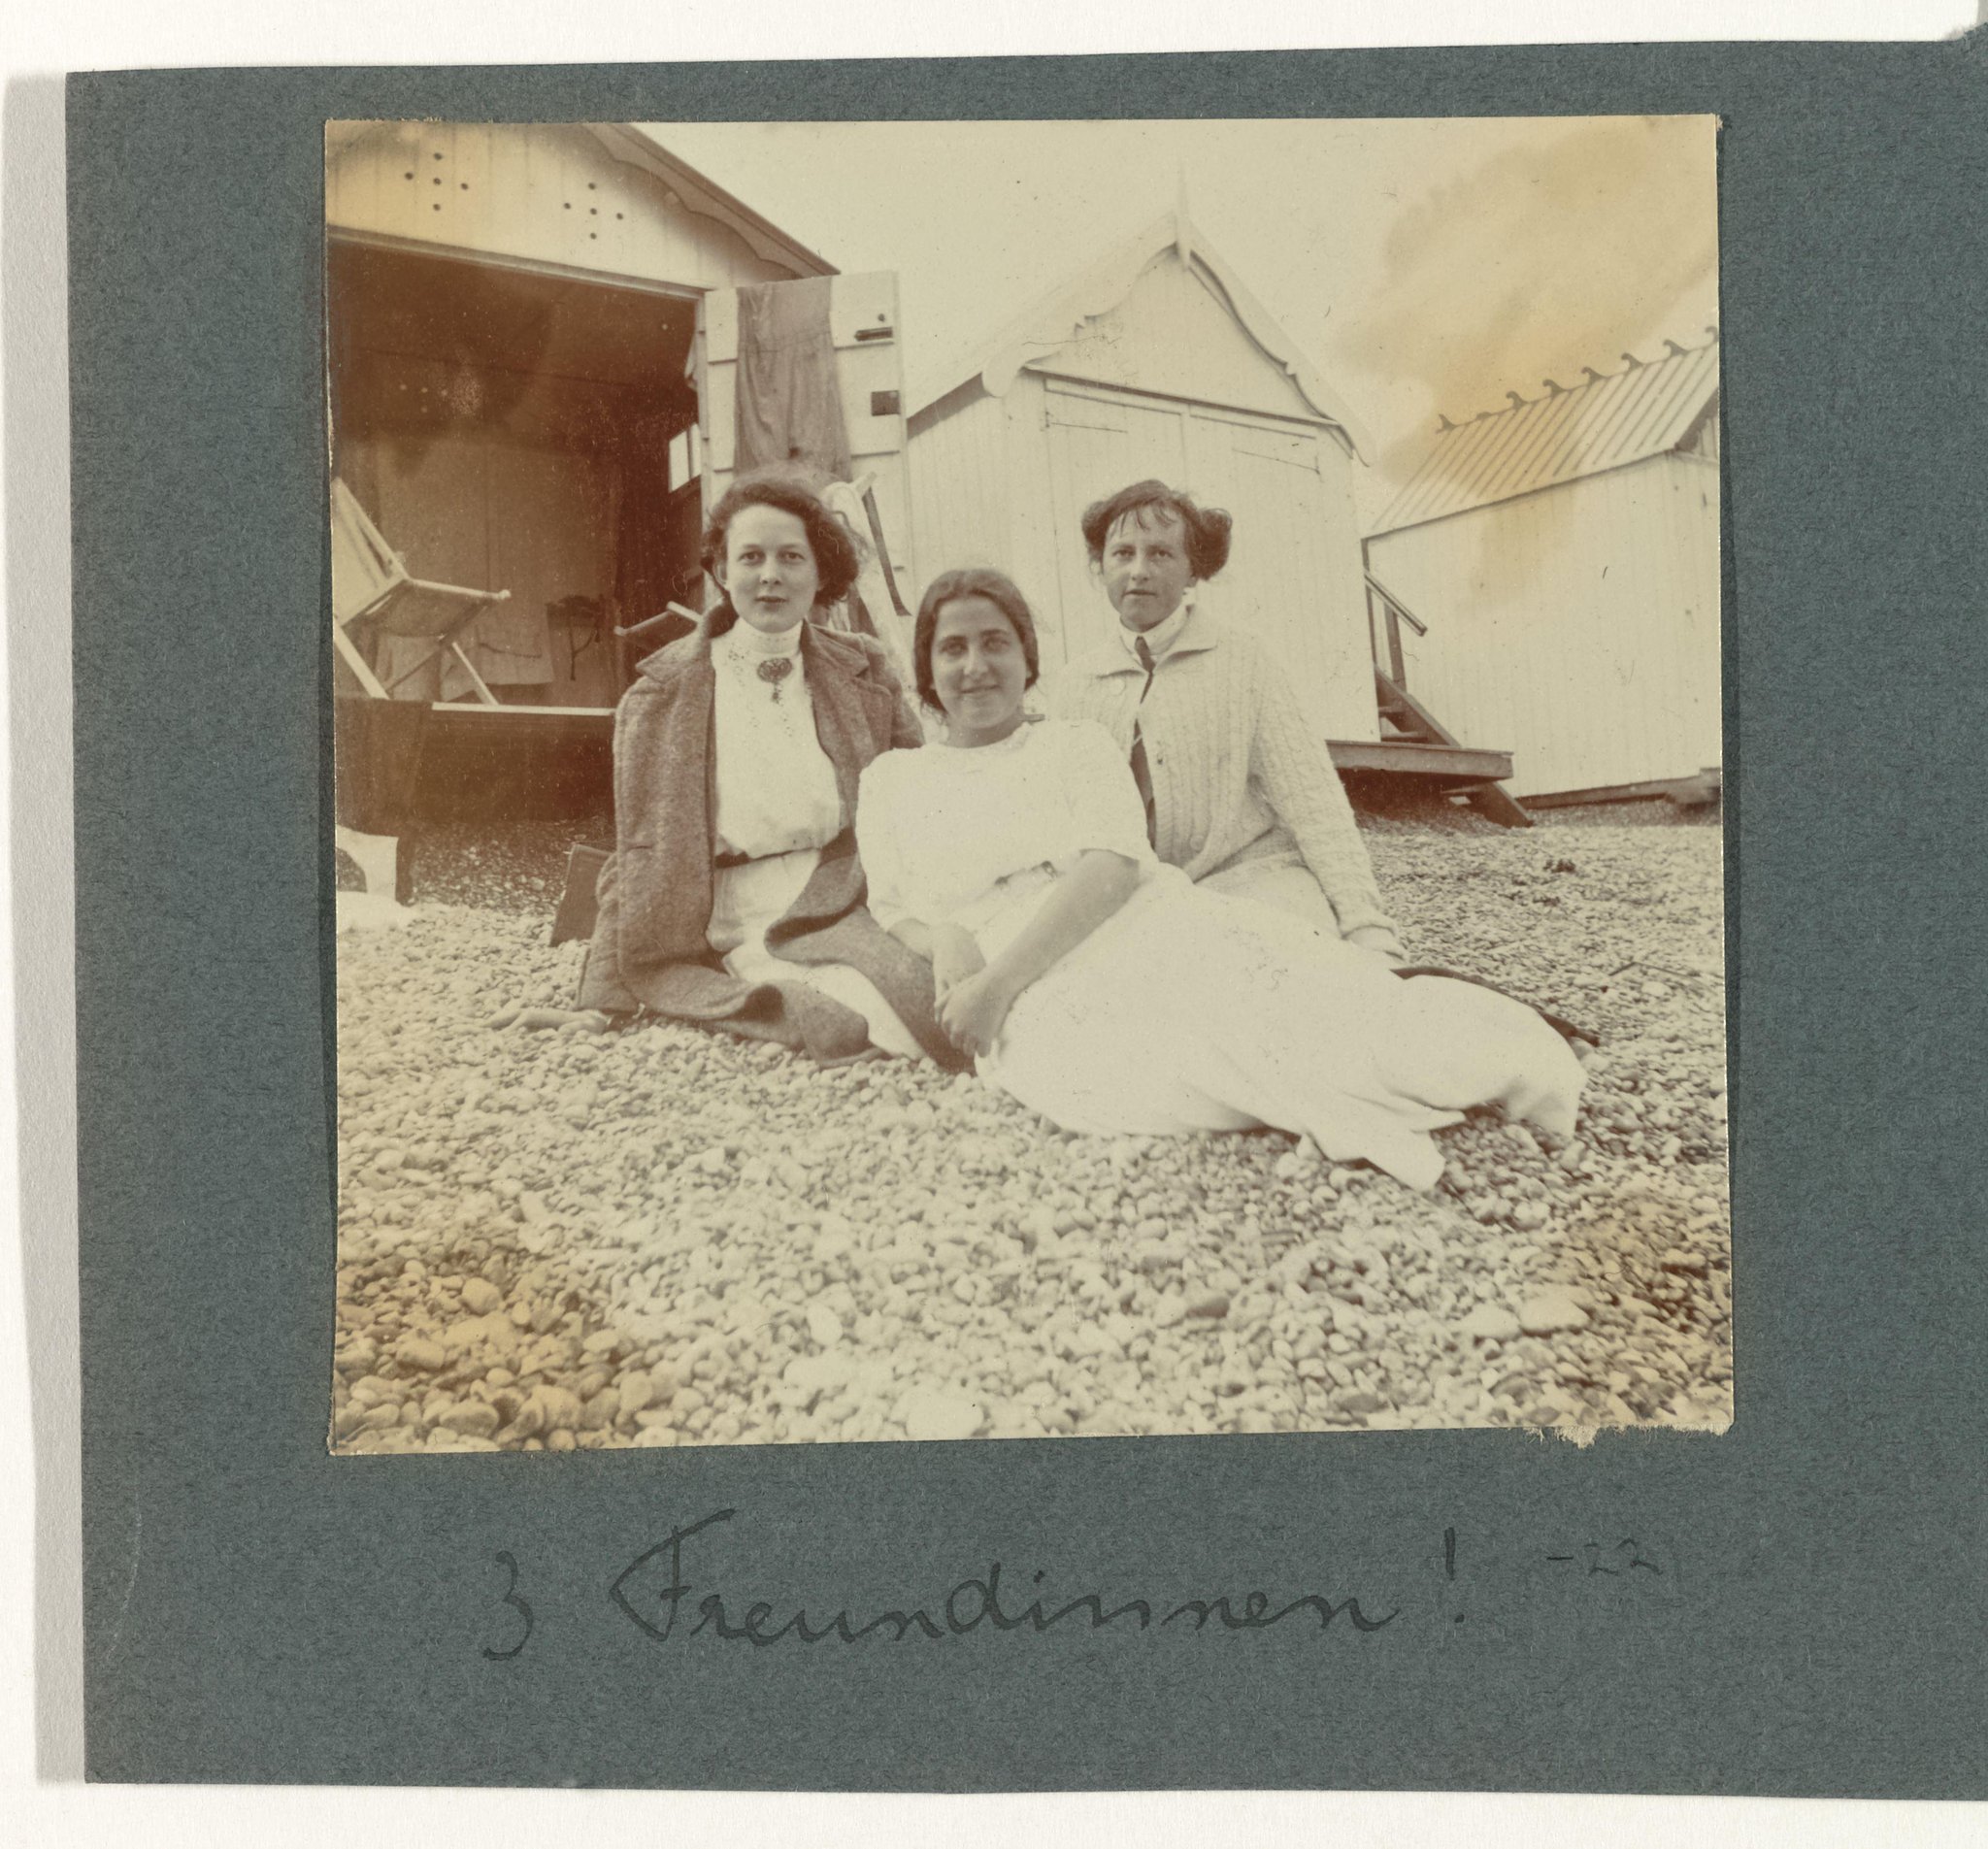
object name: photograph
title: Else Wachenheimer en twee onbekende vrouwen in vrijetijdskleding voor een strandhuisje op het strand, Bexhill-on-Sea in Engeland, 1913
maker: Anonymous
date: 1913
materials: photographic support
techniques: gelatin silver print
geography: bexhill-on-sea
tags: else wachenheimer-moos, england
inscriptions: inscription: ‘3 Freundinnen!’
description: Else Wachenheimer en twee onbekende vrouwen in vrijetijdskleding voor een strandhuisje op het strand, Bexhill-on-Sea in Engeland.